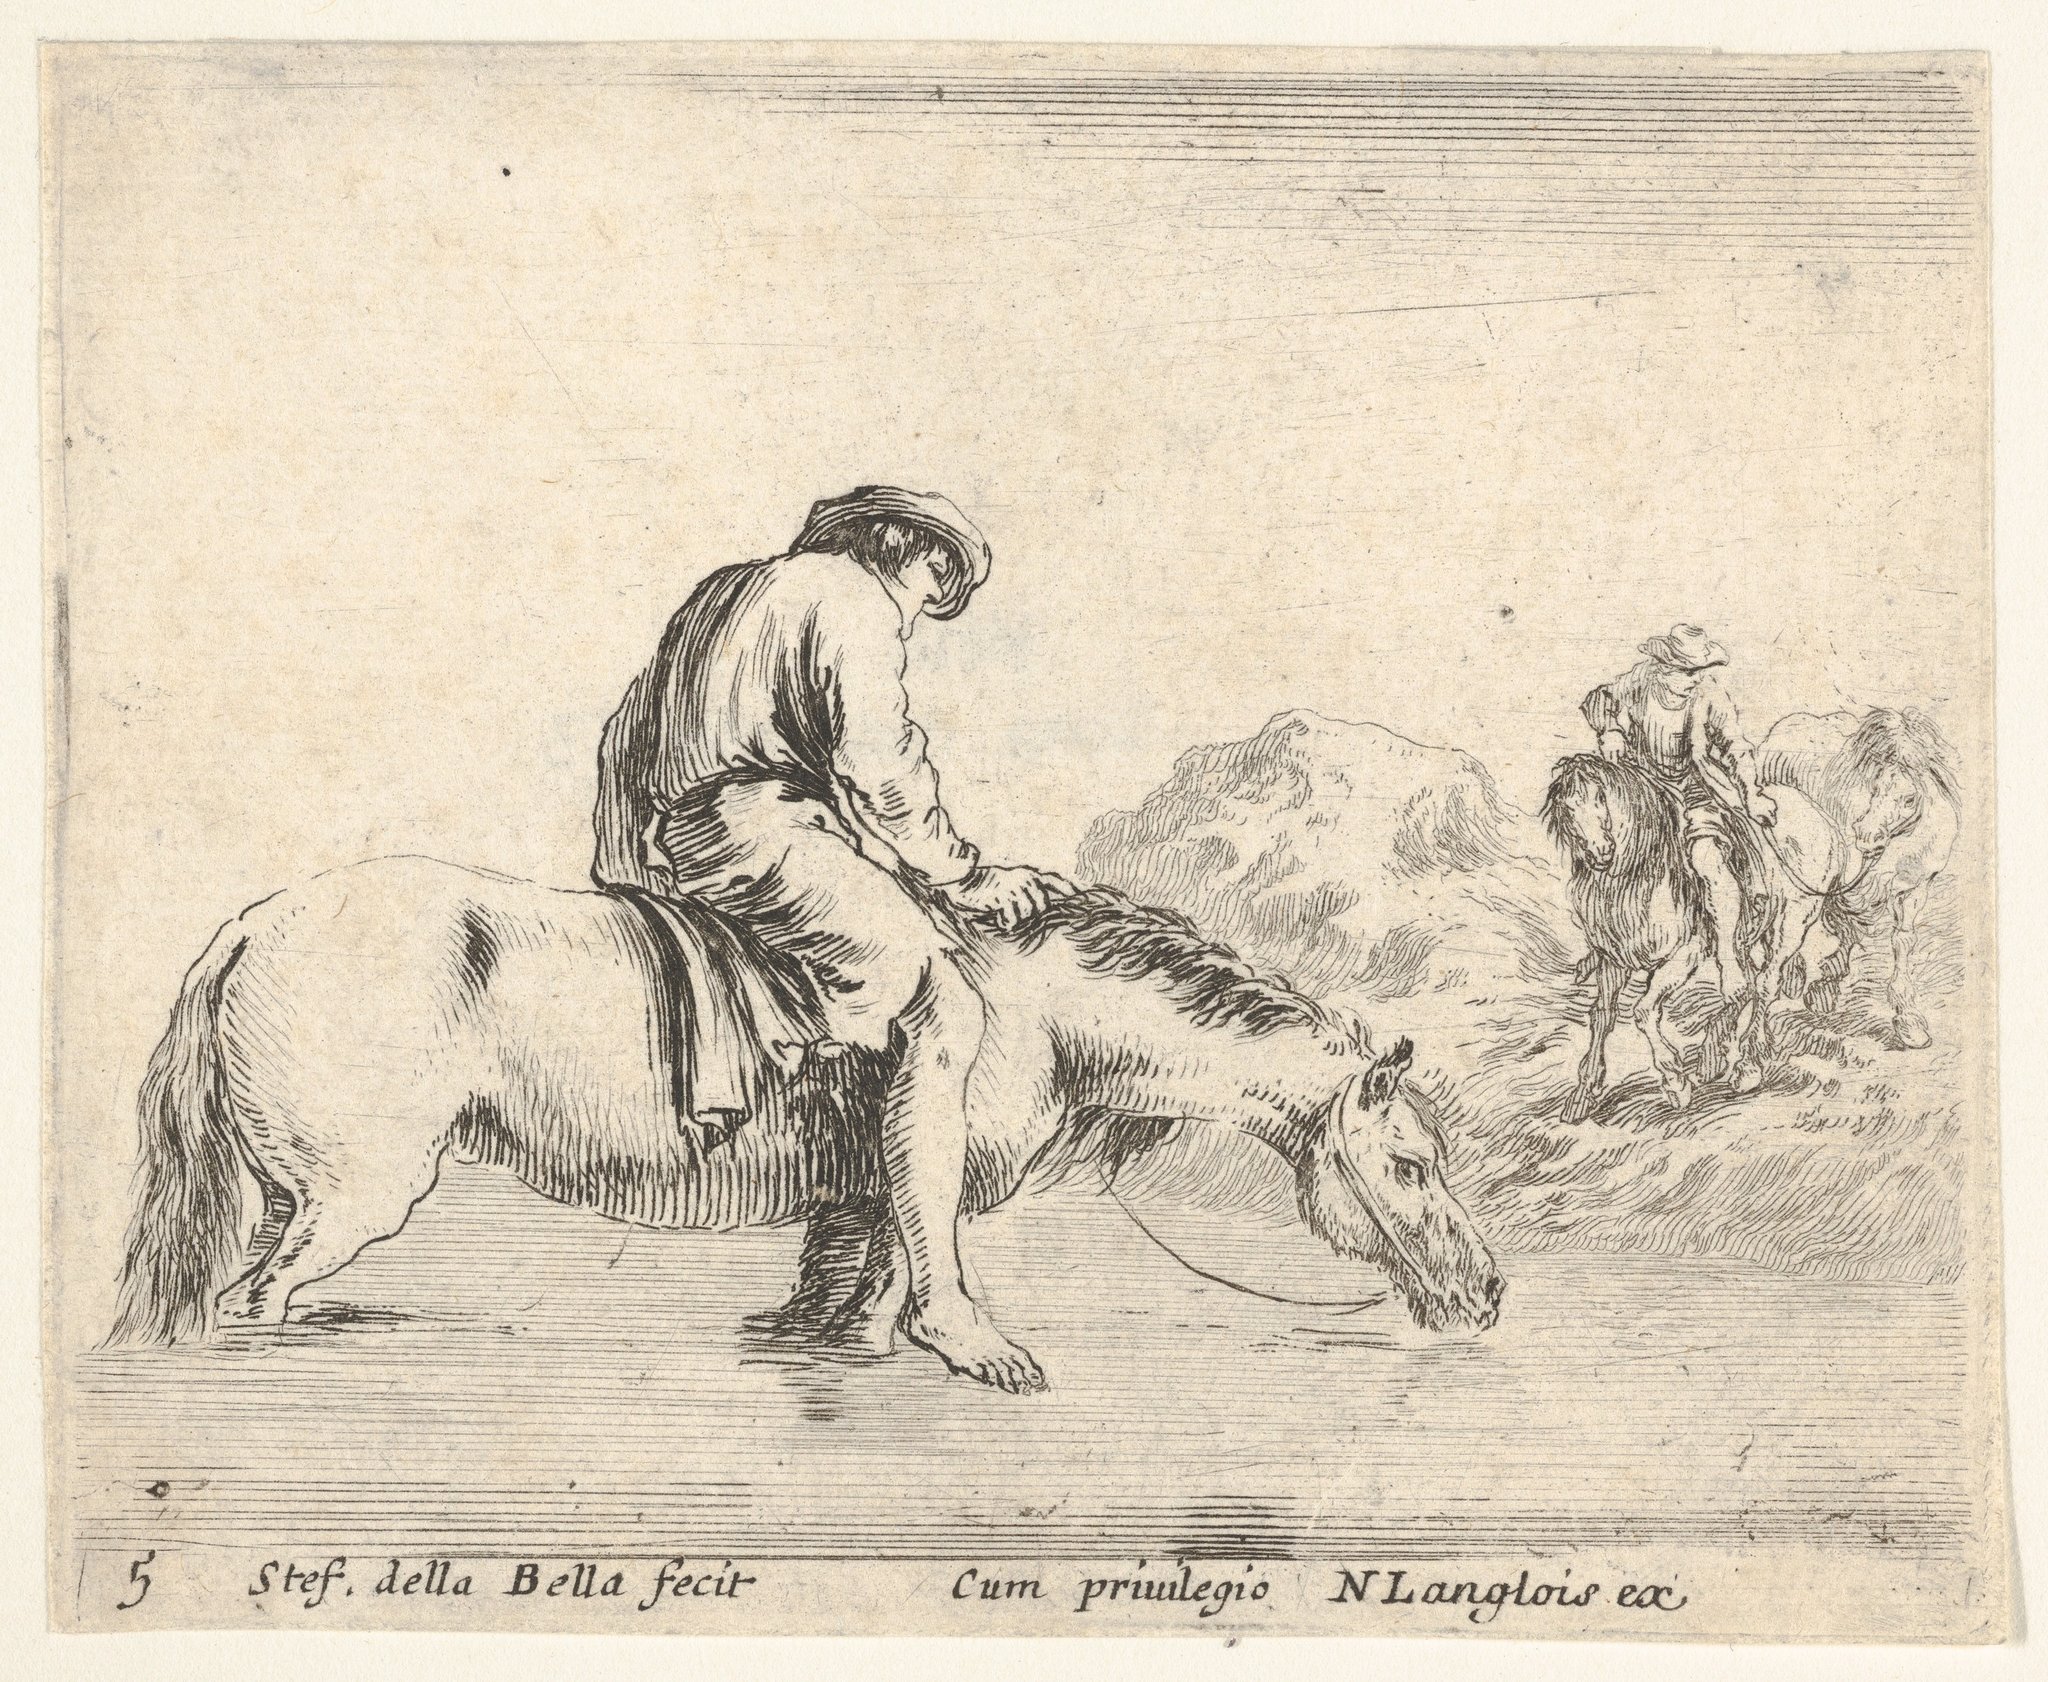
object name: print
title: Plate 5: a barefoot peasant on horseback crossing a river, another peasant on horseback and leading a horse on a bank to right in the background, from "Diversi Capricci"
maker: stefano della bella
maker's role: artist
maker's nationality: italian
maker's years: 1610-1664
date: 1644-1647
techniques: etching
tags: men,horses,rivers